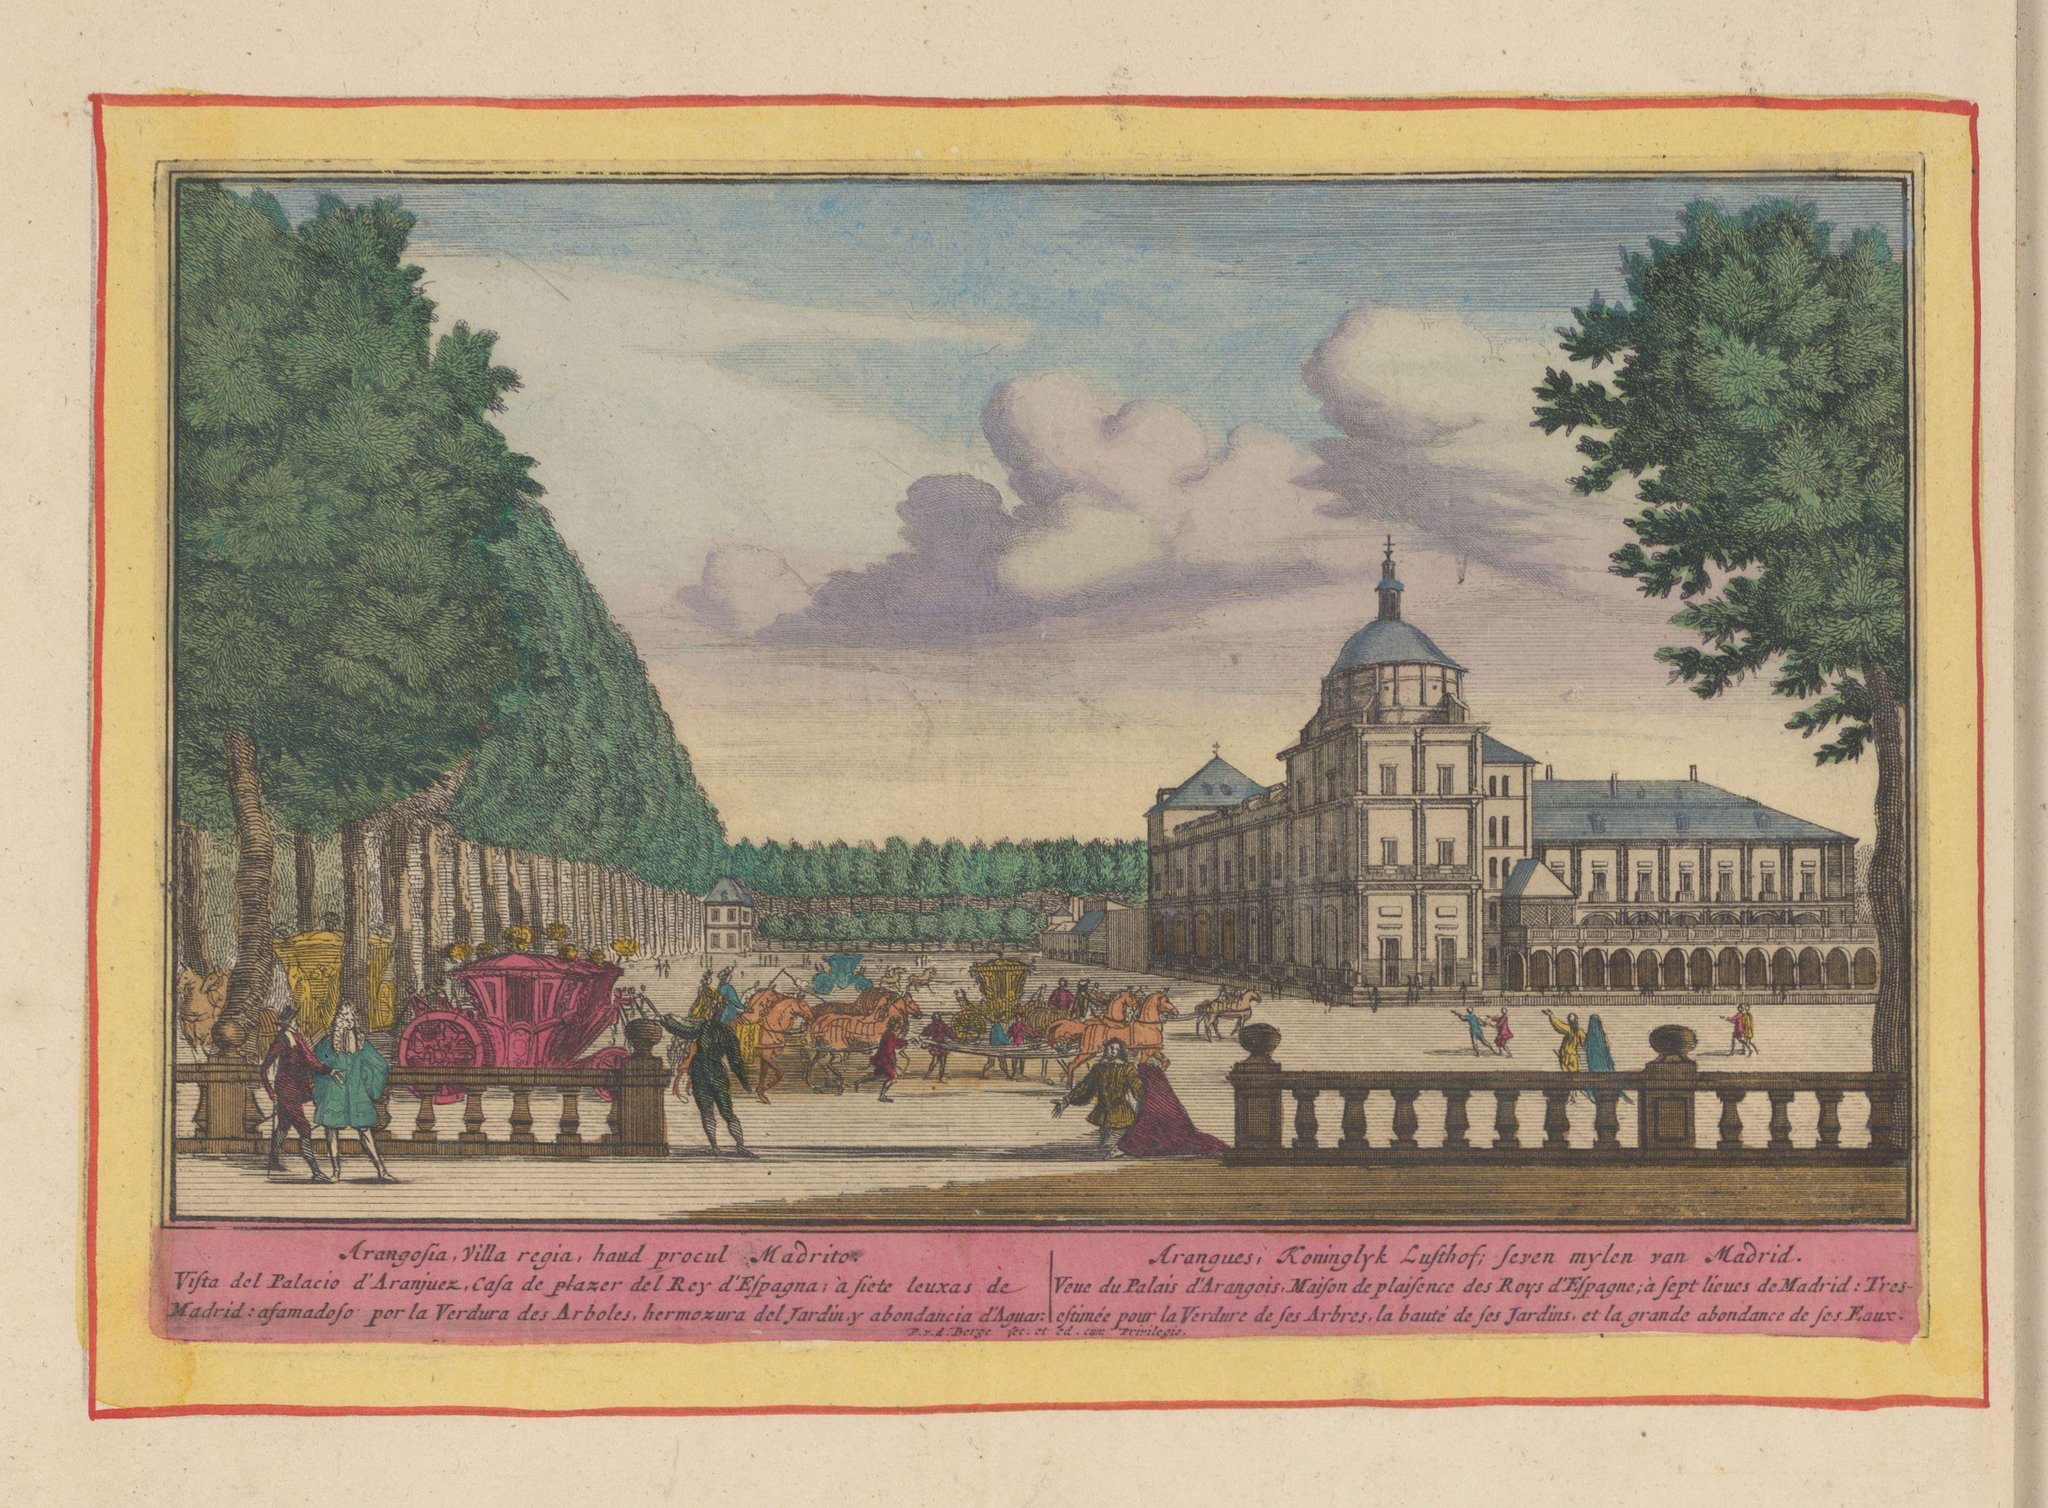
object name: print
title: Aranguez, Koninklyk Lusthof, seven mylen van Madrid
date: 1694-1737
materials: paper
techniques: etching, hand coloring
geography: amsterdam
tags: palace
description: Prent uit: Theatrum Hispaniæ, exhibens regni urbes, villas ac viridaria magis illustria. Het aanmerkelykste en voortreffelykste in Spanjen (...). Amsterdam: Pieter van den Berge, ca. 1694-1737.